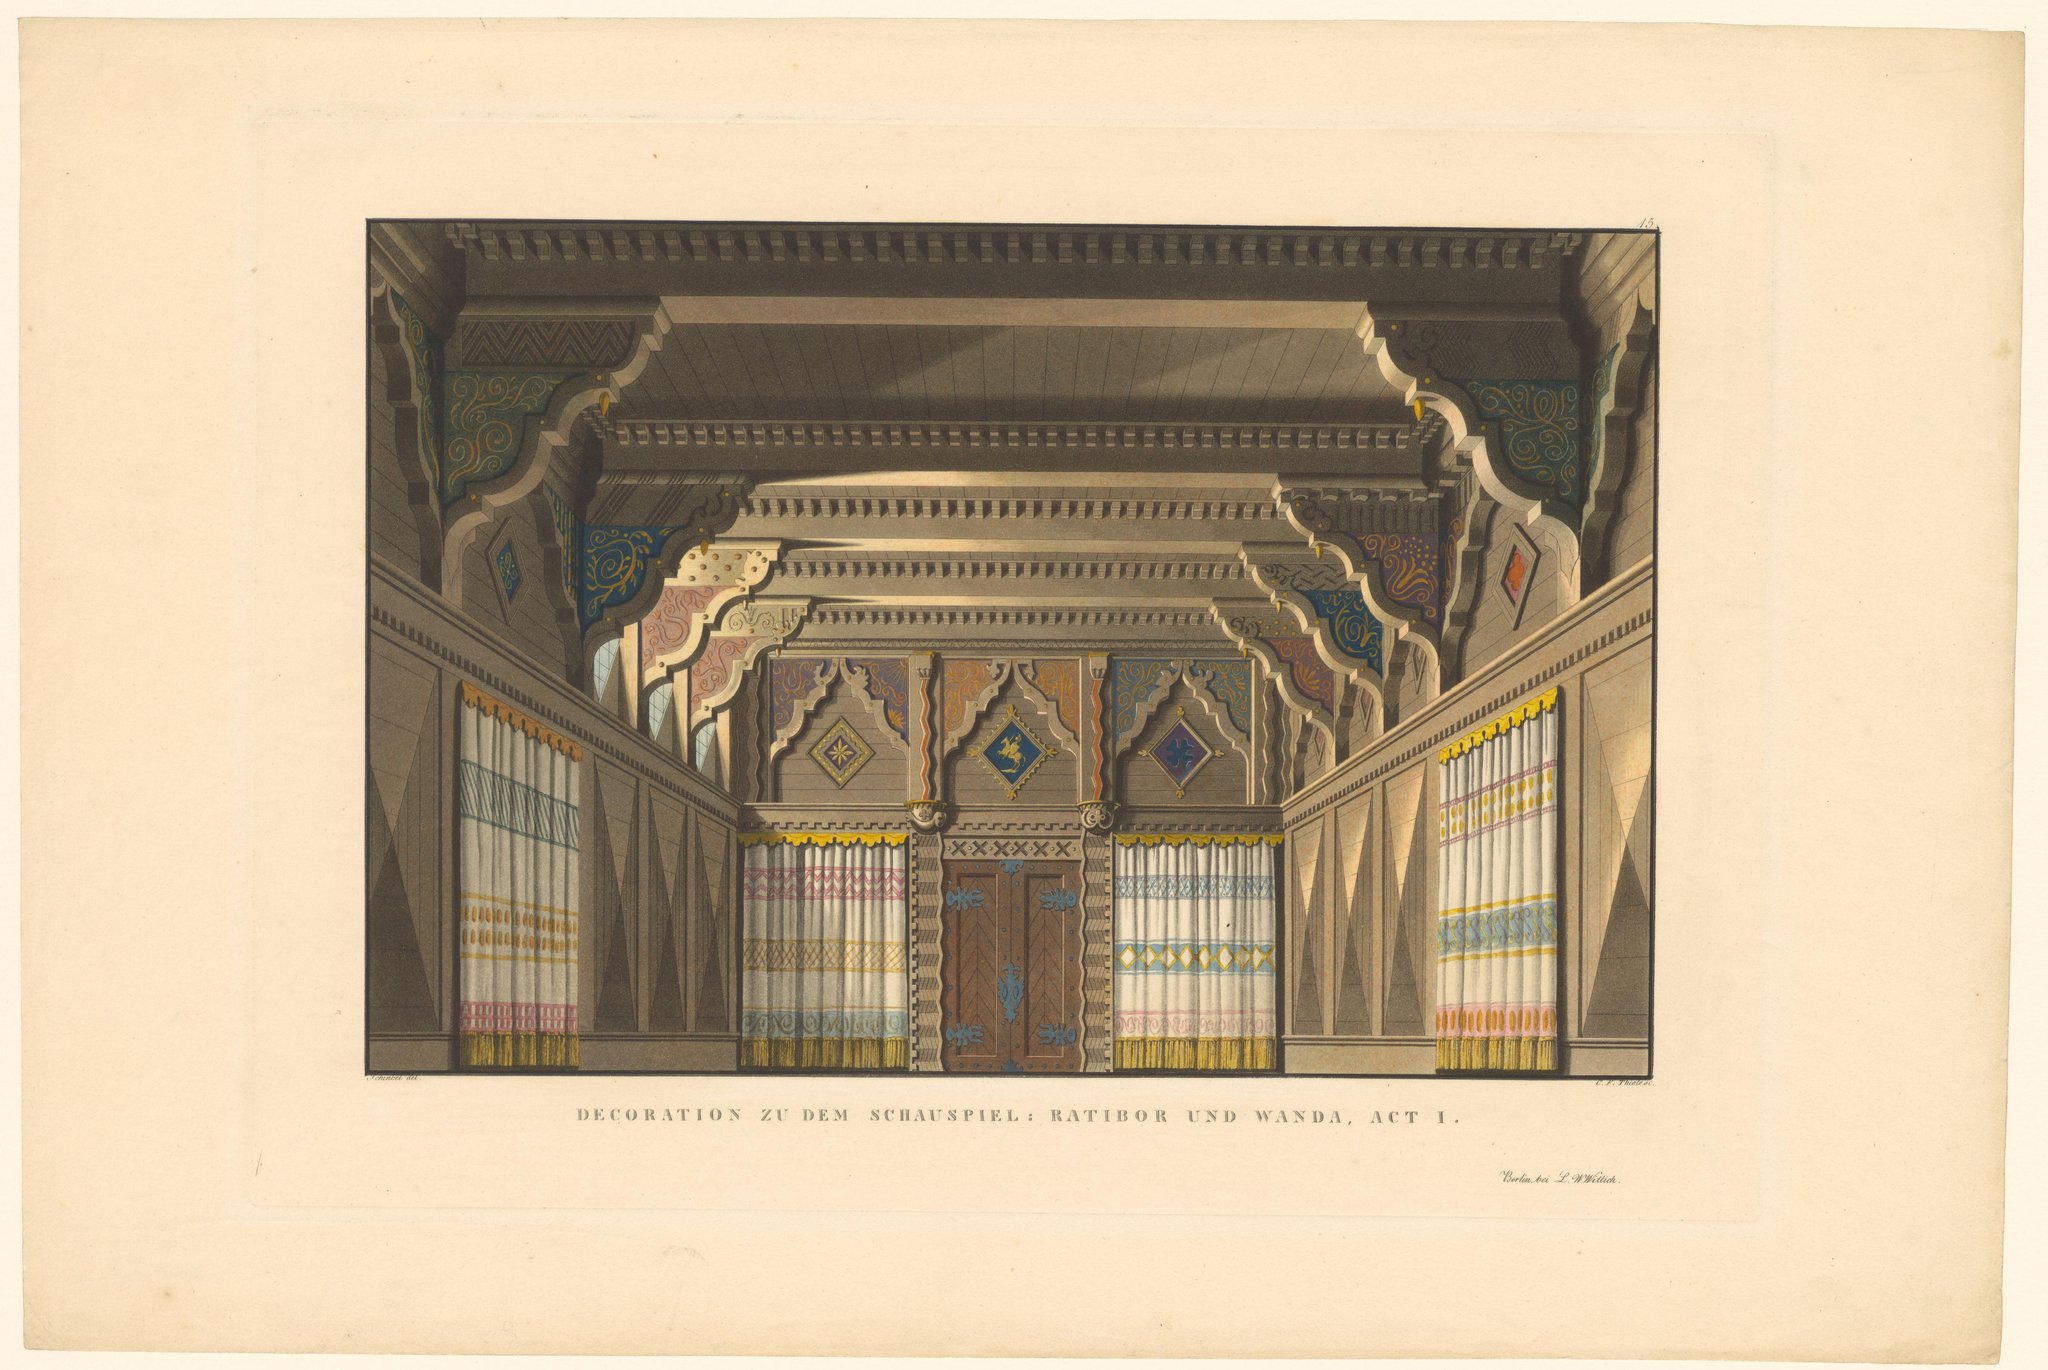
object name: print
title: Decorationen auf den beiden Königlichen Theatern in Berlin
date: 1824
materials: paper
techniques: aquatint, engraving, hand coloring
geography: berlin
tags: stage design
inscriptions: collector's mark: Lugt 2760, collector's mark: Lugt 2228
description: Weergave van een decor uit een toneelstuk door Jakob Andreas Konrad Levezow.